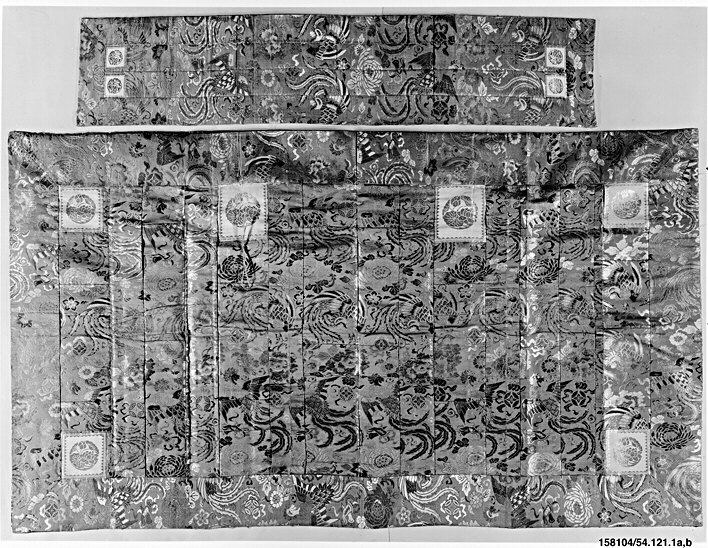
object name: robe, priest's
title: Priest's Robe and Stole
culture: japanese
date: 1801-1900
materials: metal thread, silk